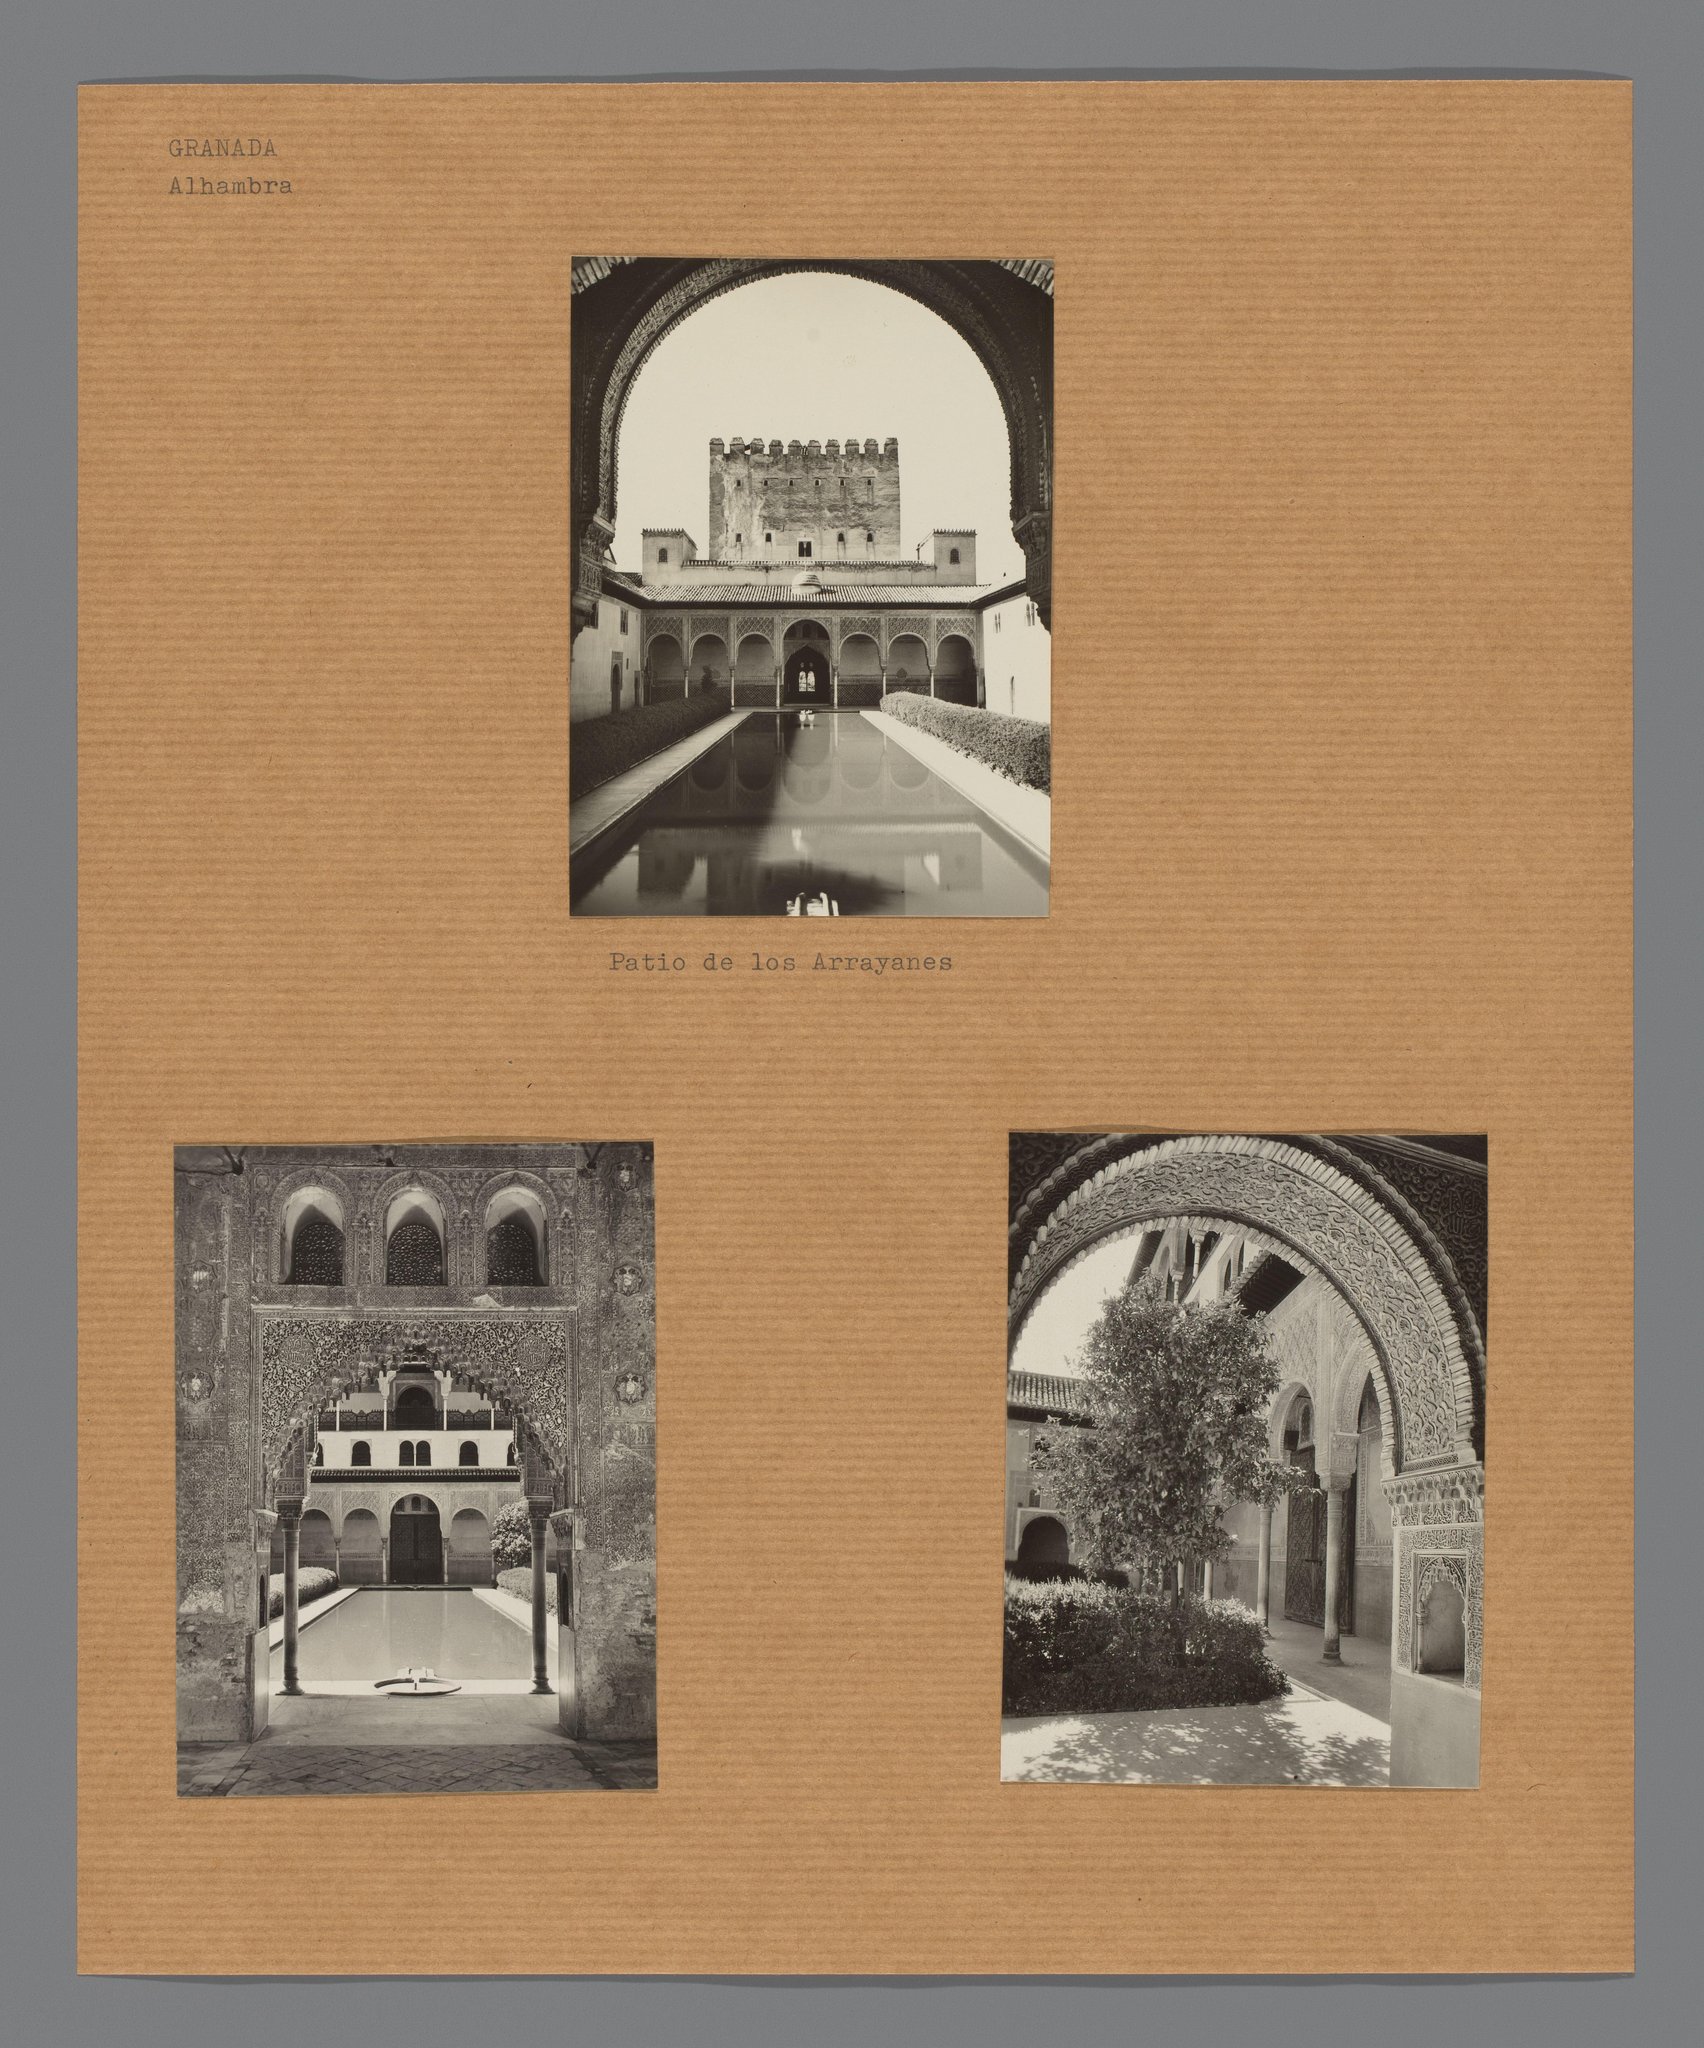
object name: photograph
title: Alhambra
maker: Anonymous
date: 1885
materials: paper, photographic support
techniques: gelatin silver print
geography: spain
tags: alhambra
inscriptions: stamp: ‘UNIVERSITEIT VAN AMSTERDAM / KUNST / HISTORISCH / INSTITUUT’, inscription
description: Vel met drie foto's uit de studiecollectie van het Kunsthistorisch Instituut van de Universiteit van Amsterdam.